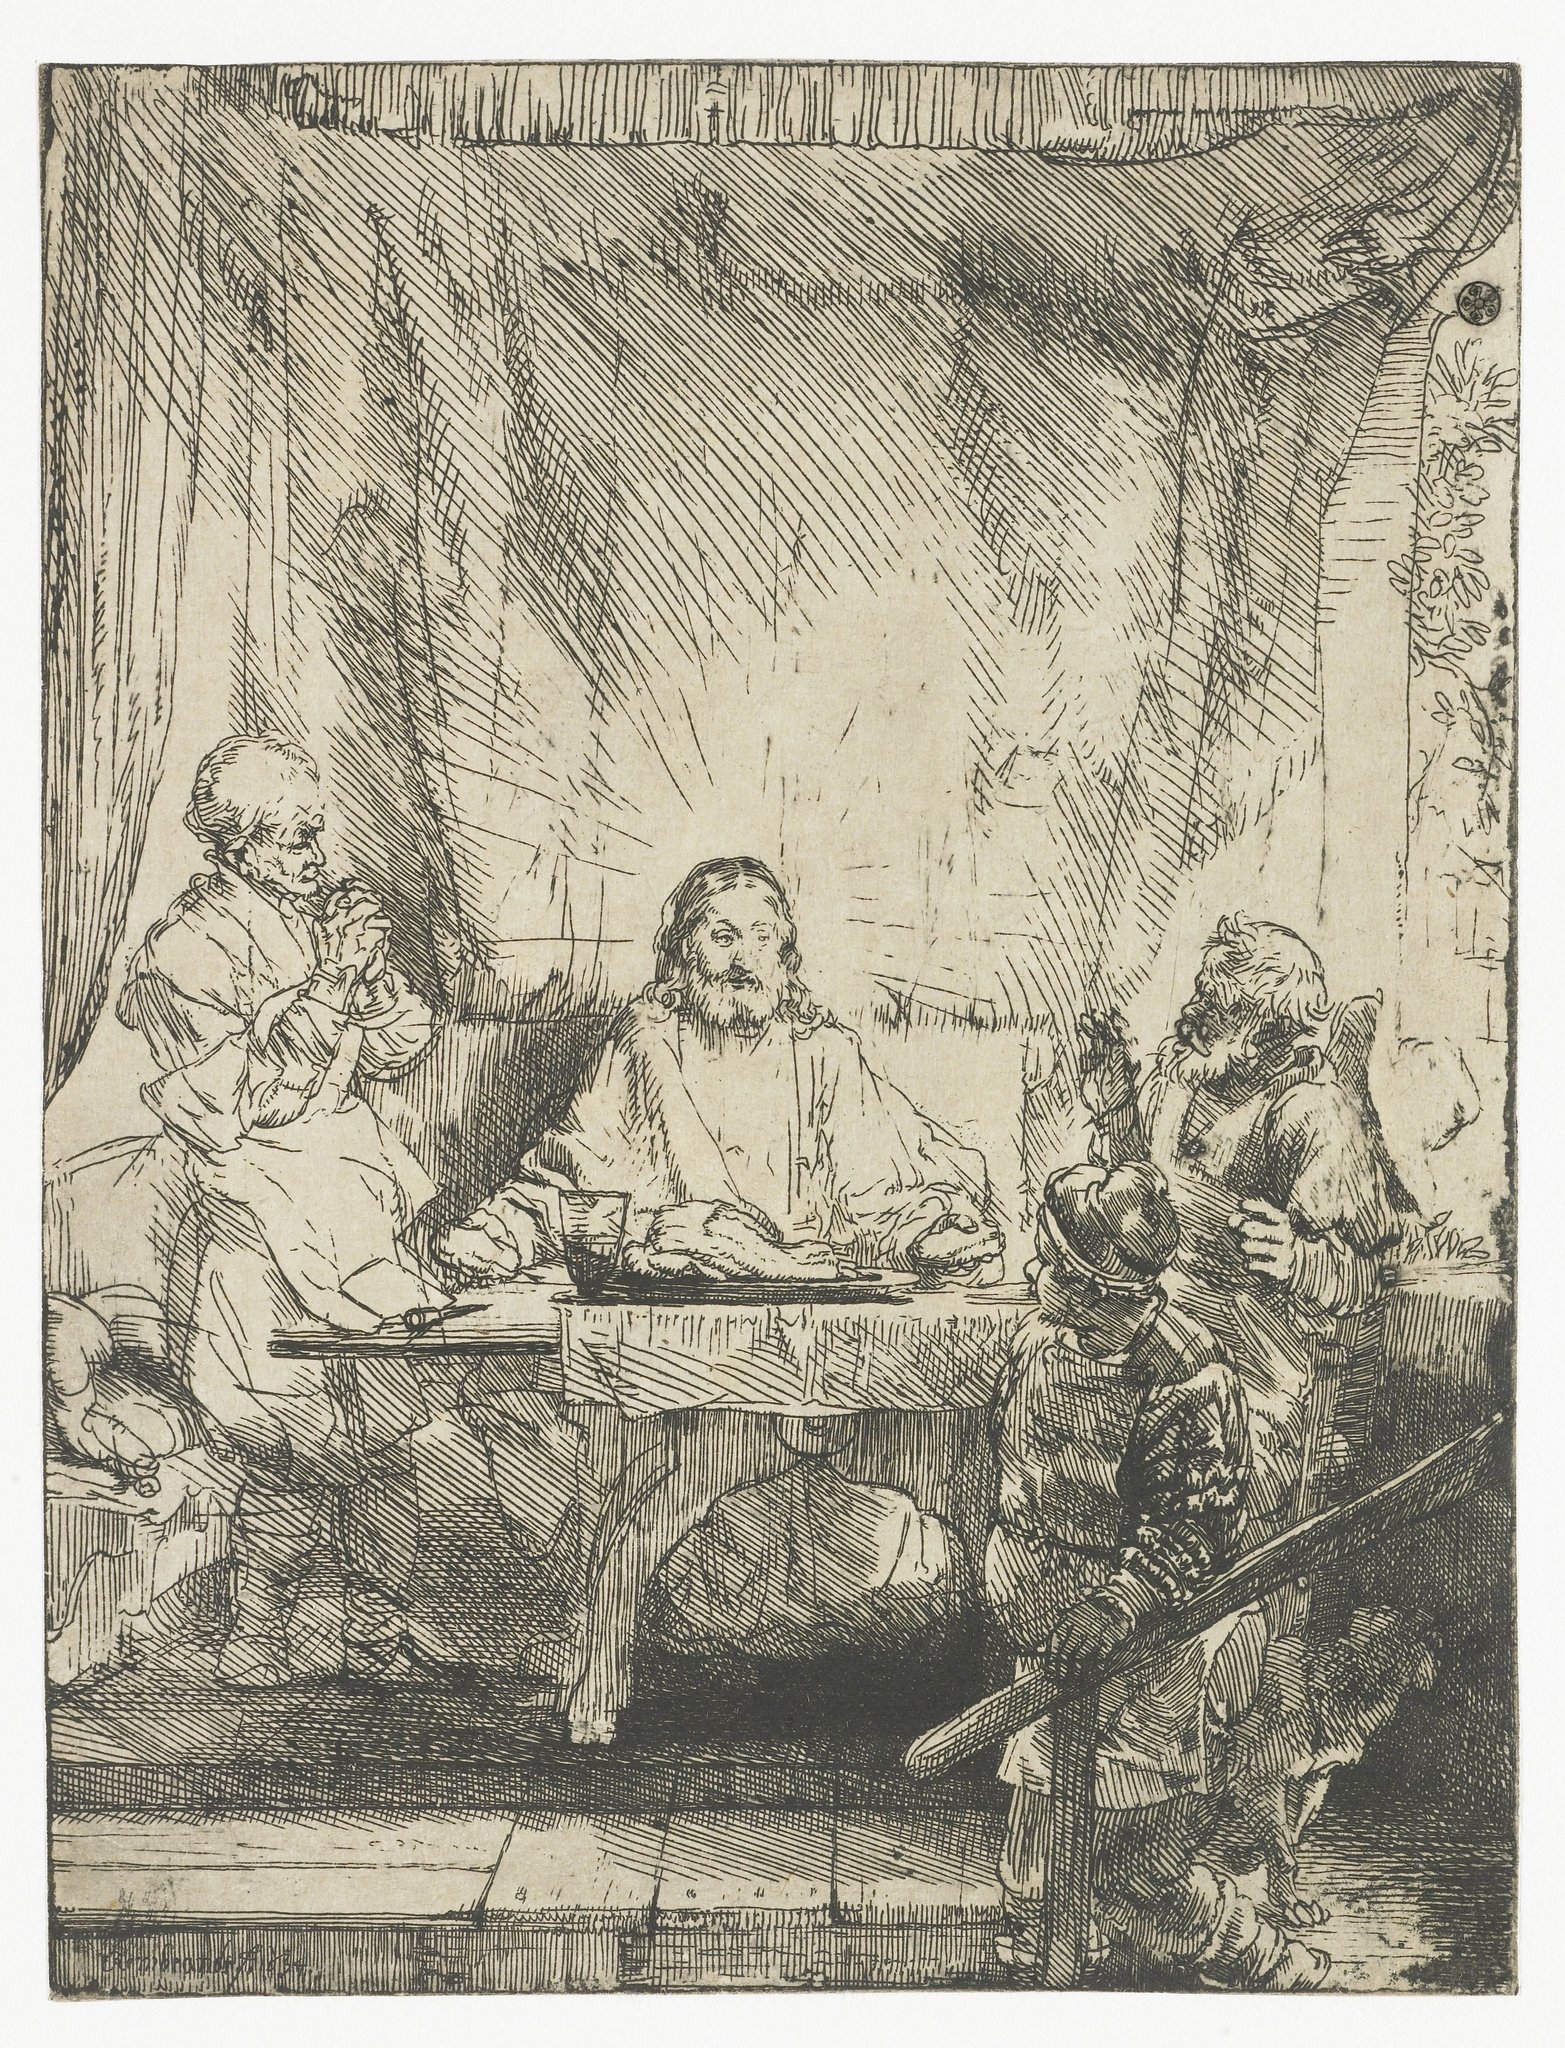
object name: print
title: Christ at Emmaus: the larger plate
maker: rembrandt van rijn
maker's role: draughtsman, painter, print maker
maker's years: 1606-1669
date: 1654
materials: paper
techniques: etching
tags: the supper at emmaus: christ is recognized while blessing or breaking the bread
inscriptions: mark: Lugt 2228, mark: Lugt 2775, signature and date: ‘Rembrandt f. 1654’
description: Three days after Christ had risen from the dead, two of his disciples encountered him on the road to Emmaus. They only became aware of their travelling companion’s true identity while sharing a meal together later that day. This is the moment Rembrandt depicted here. For the beholder, too, it is clear that the figure seated beneath a kind of baldachin and emanating a heavenly light can only be Christ.